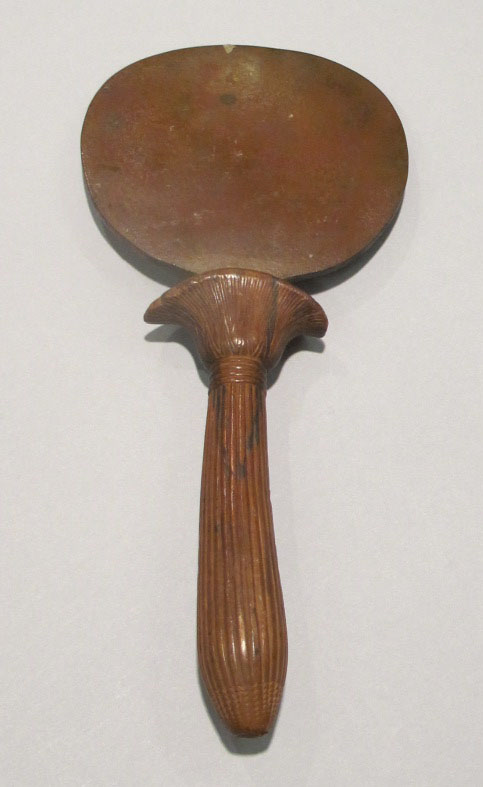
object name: mirror, papyrus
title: Mirror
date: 1550-1295 BCE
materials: bronze, copper alloy, wood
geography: egypt